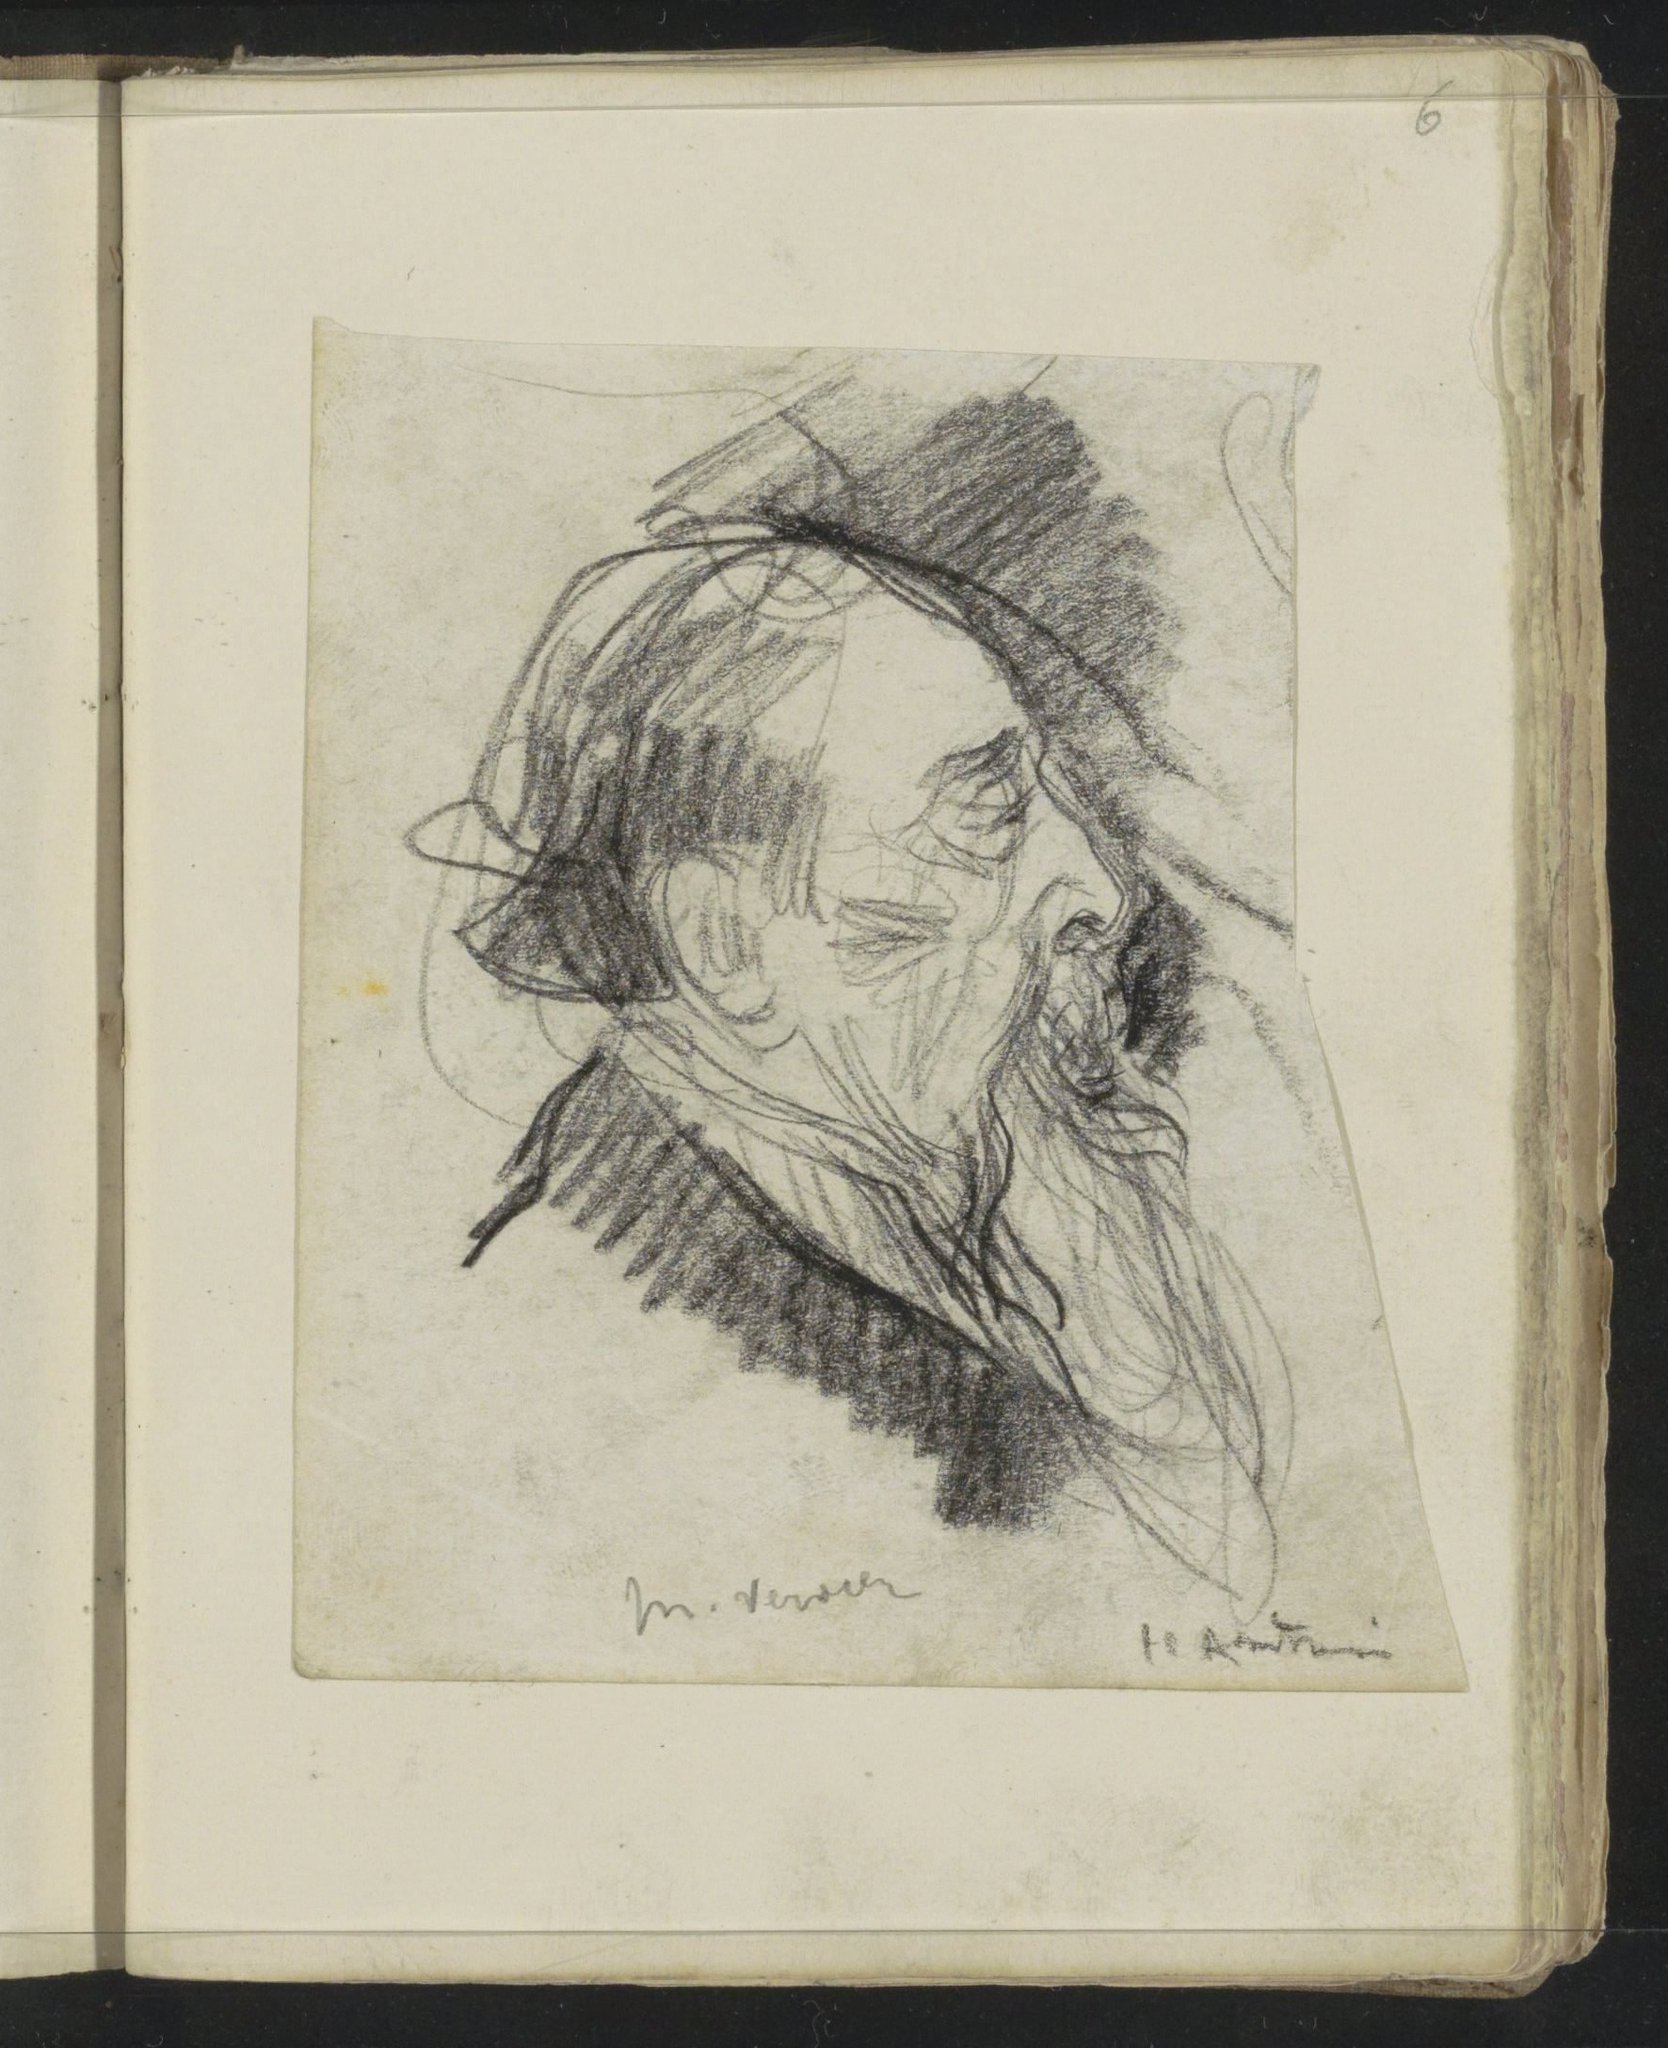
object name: sketchbook leaf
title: Portret van kunstenaar Maurits Verveer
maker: floris arntzenius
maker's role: draughtsman, print maker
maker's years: 1864-1925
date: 1883-1914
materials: chalk, paper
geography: the hague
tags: painter, maurits verveer, portrait, self-portrait of artist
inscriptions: name: ‘M. Verveer’, signature: ‘Fl. Arntzenius’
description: Pagina 6 uit een schetsboek met 82 pagina's.